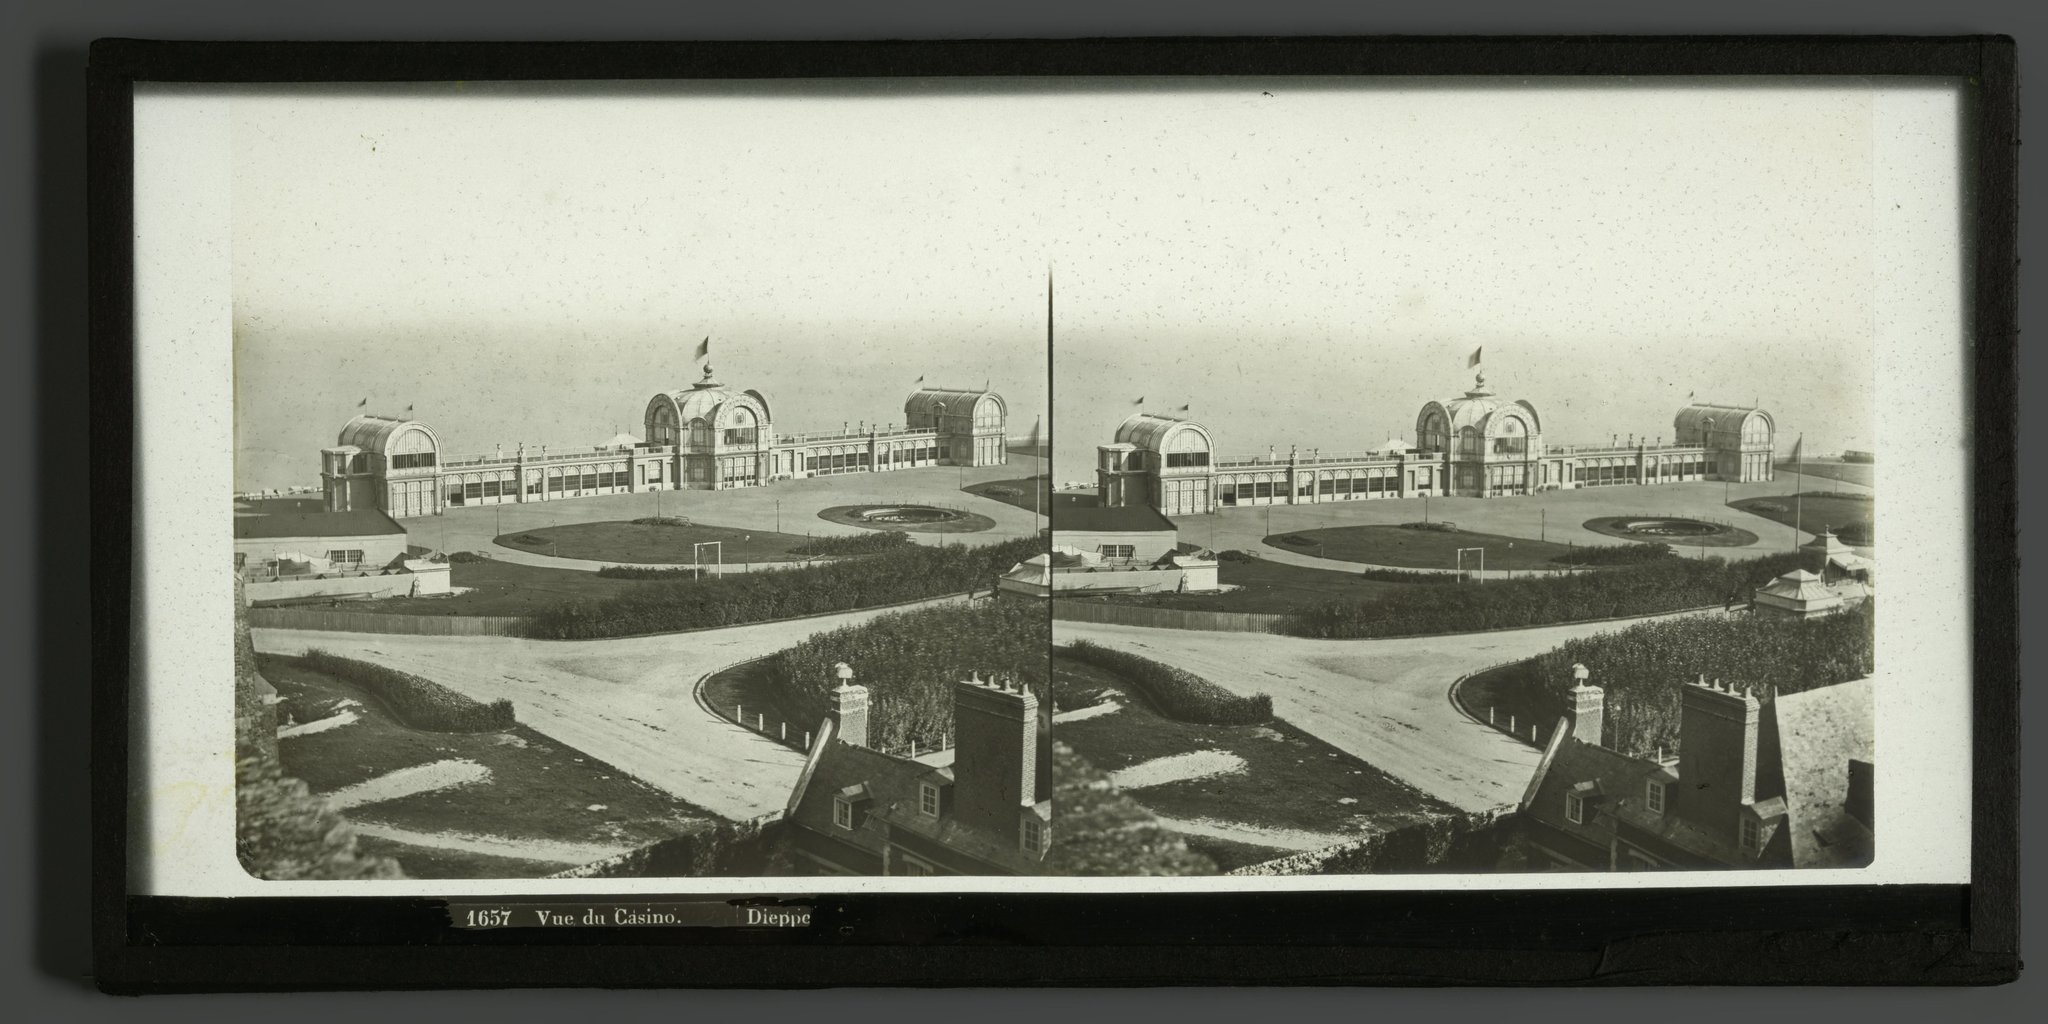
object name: photograph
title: Gezicht op het casino te Dieppe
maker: Anonymous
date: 1860-1890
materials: glass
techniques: slide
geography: dieppe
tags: casino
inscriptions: number: ‘1657’